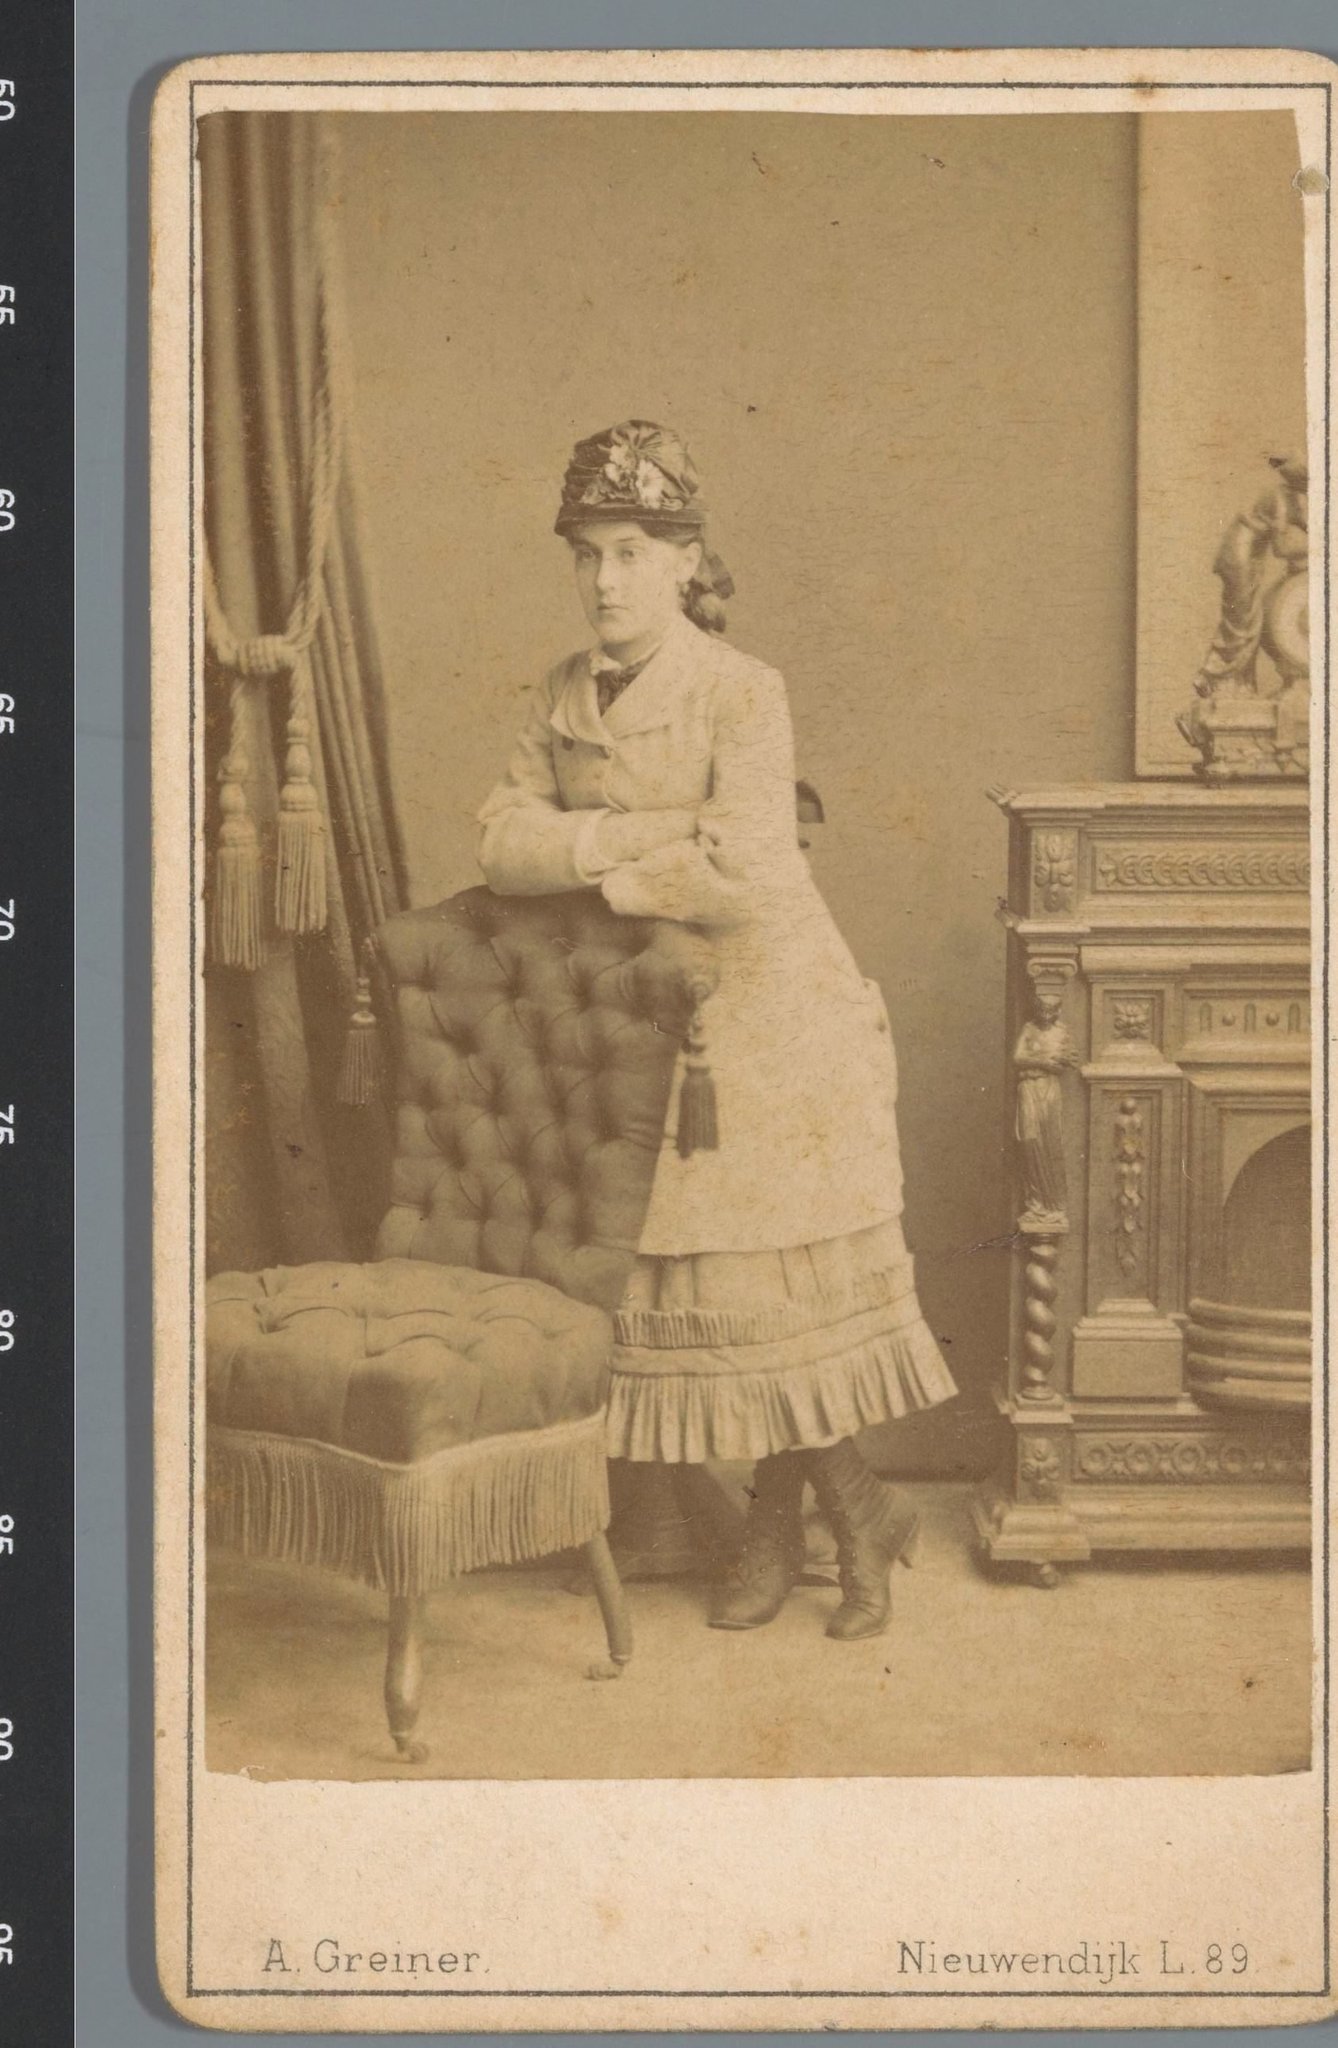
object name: carte de visite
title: Portret van een onbekende vrouw, leunend over de rugleuning van een stoel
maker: albert greiner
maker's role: fotograaf, fotostudio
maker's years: 1833-1890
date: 1874-1887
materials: cardboard, paper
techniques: albumen print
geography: amsterdam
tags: historical persons - bb - woman, chair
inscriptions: inscription: ‘AG/ 1878/ VERDIENSTE/ A. GREINER/ Photograf/ AMSTERDAM/ NIEUWENDIJK L. 89.’